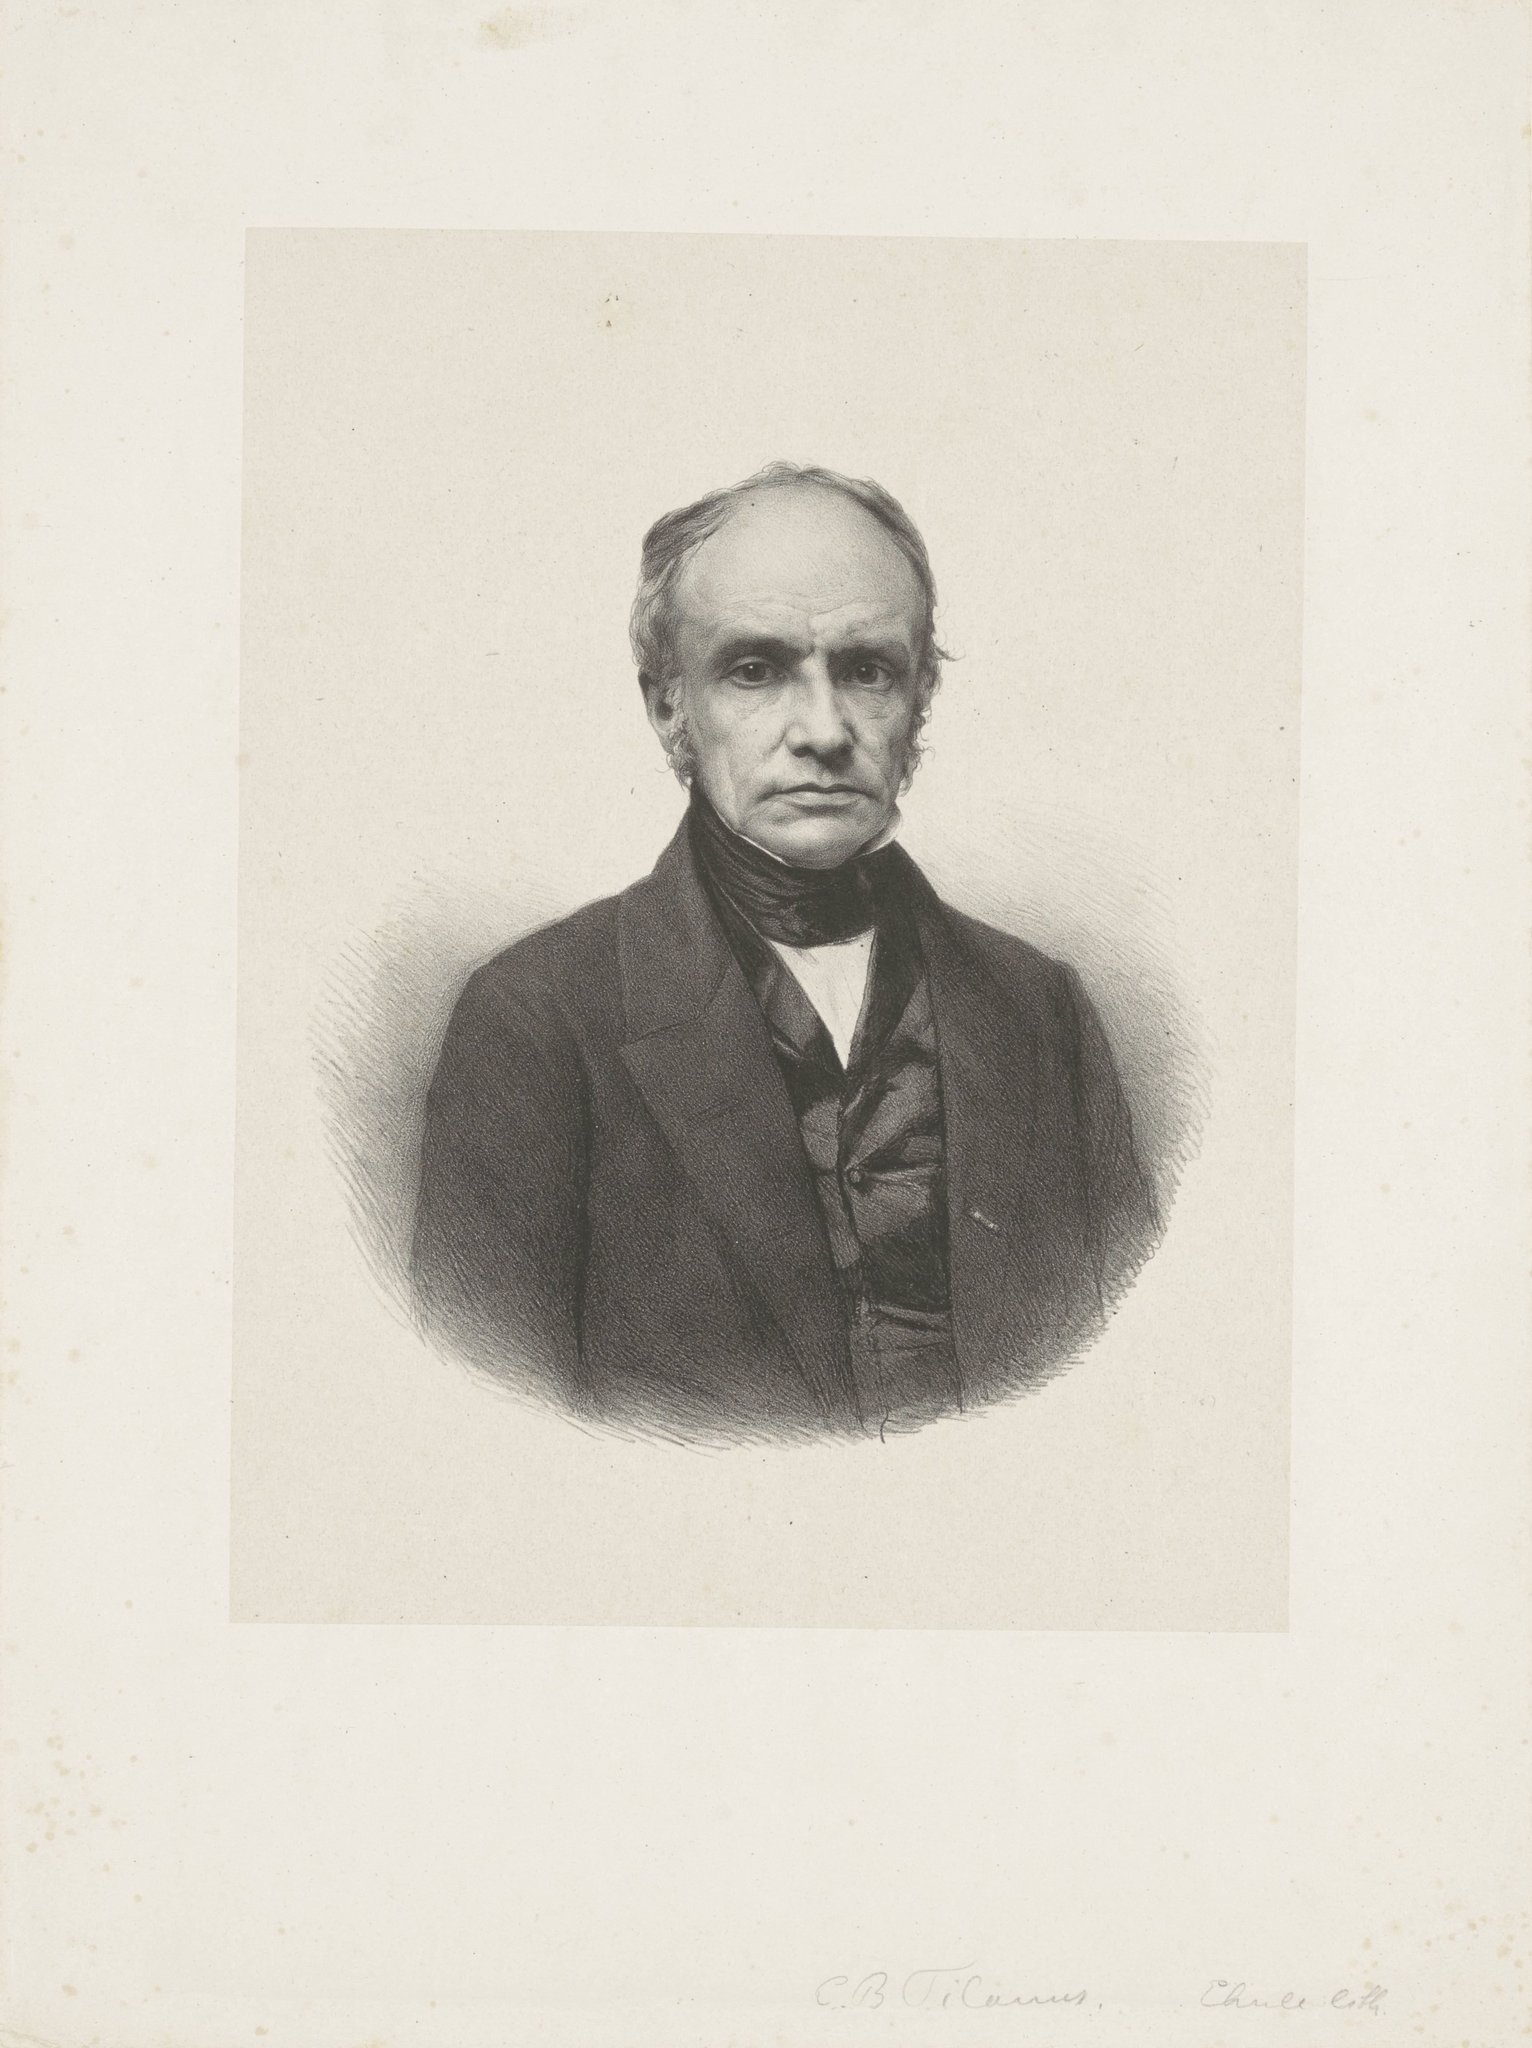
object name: print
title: Portret van Christiaan Bernhard Tilanus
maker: adrianus johannes ehnle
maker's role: draughtsman, print maker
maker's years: 1819-1863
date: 1829-1863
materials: paper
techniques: lithograph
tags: historical persons (+ (full) bust portrait)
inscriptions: collector's mark: Lugt 2228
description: De geportretteerde draagt een ordeteken op de revers van zijn jas.